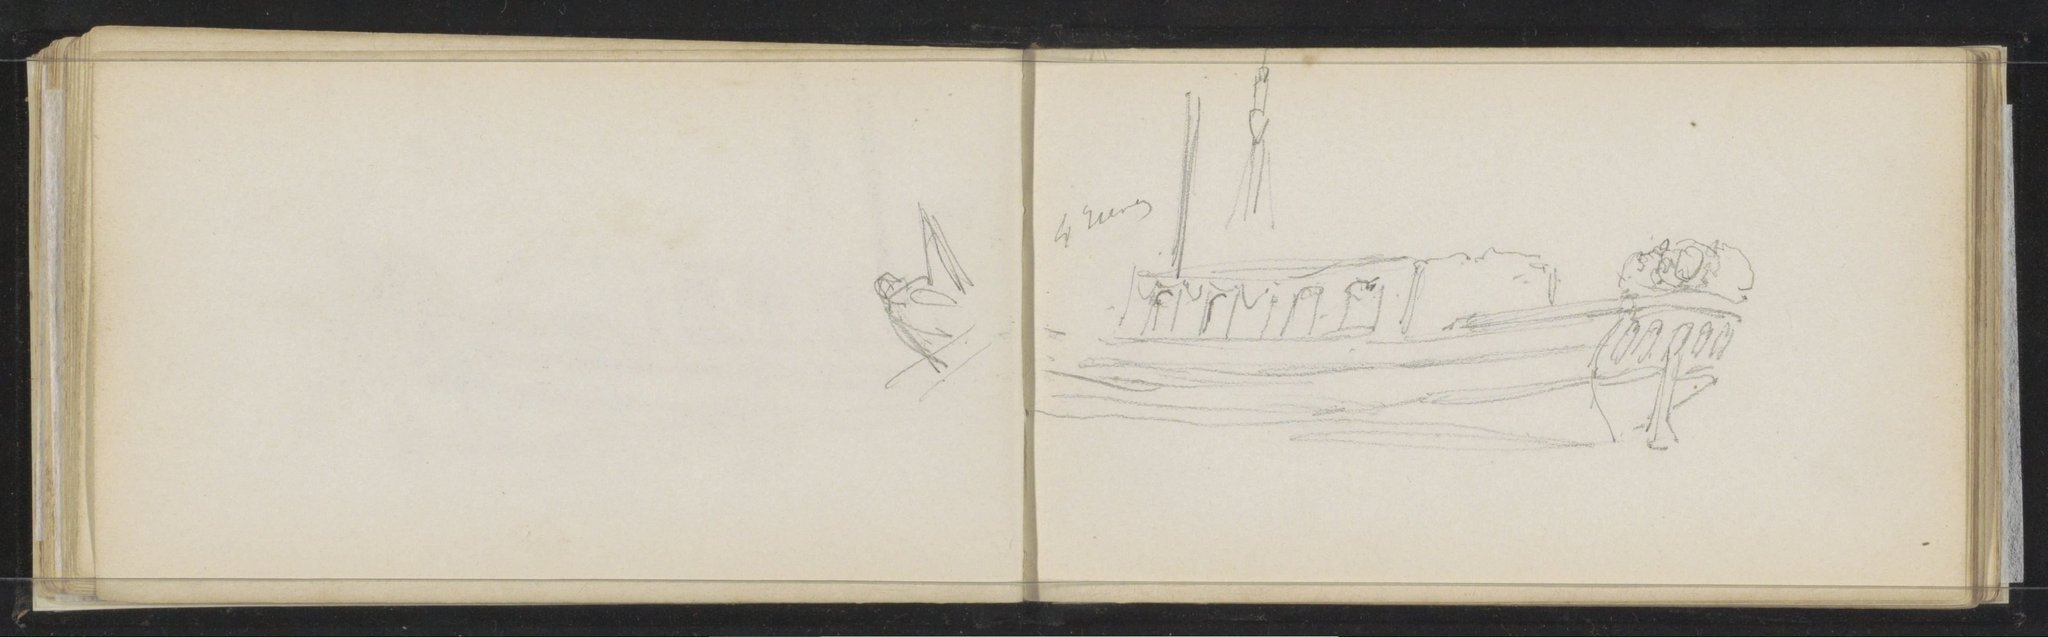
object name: sketchbook leaf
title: Boot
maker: cornelis springer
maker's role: draughtsman, painter, print maker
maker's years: 1817-1891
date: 1860-1866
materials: paper, pencil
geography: netherlands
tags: ships (in general)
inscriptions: annotation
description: Boot met een roef of kajuit. Boven een deel van de mast. Blad 22 verso en blad 23 recto uit een schetsboek met 44 bladen.